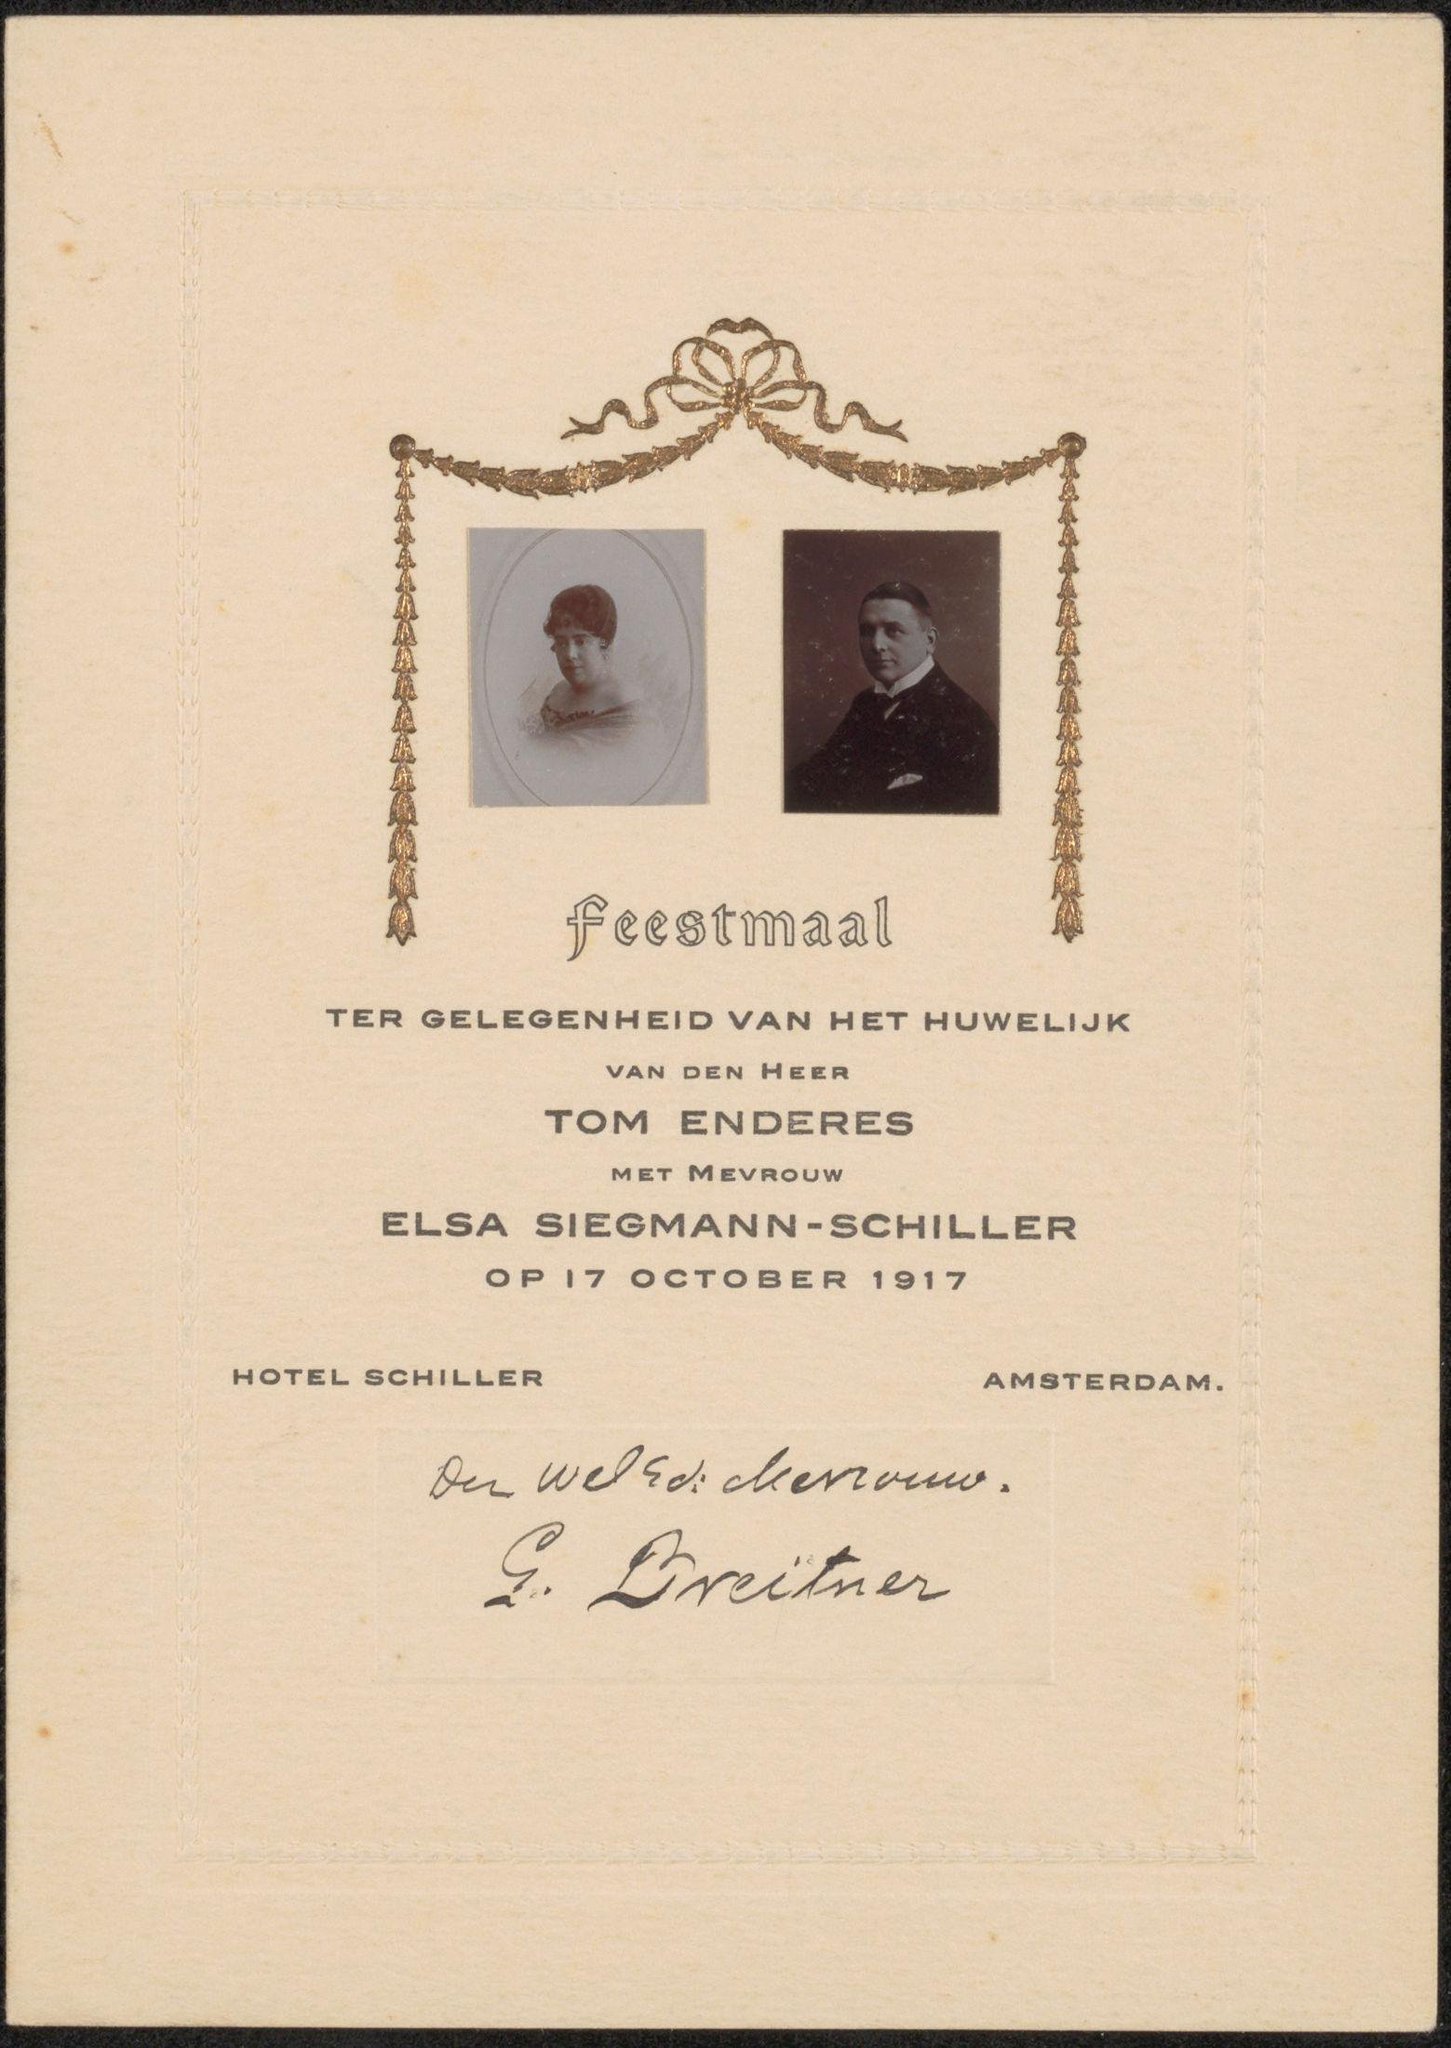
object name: invitation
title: Uitnodiging voor een feestmaal aan Marie Jordan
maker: elsa siegmann-schiller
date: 1917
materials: ink, paper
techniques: pen, writing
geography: amsterdam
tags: elsa siegmann-schiller, marie jordan, historical persons (portraits and scenes from the life)